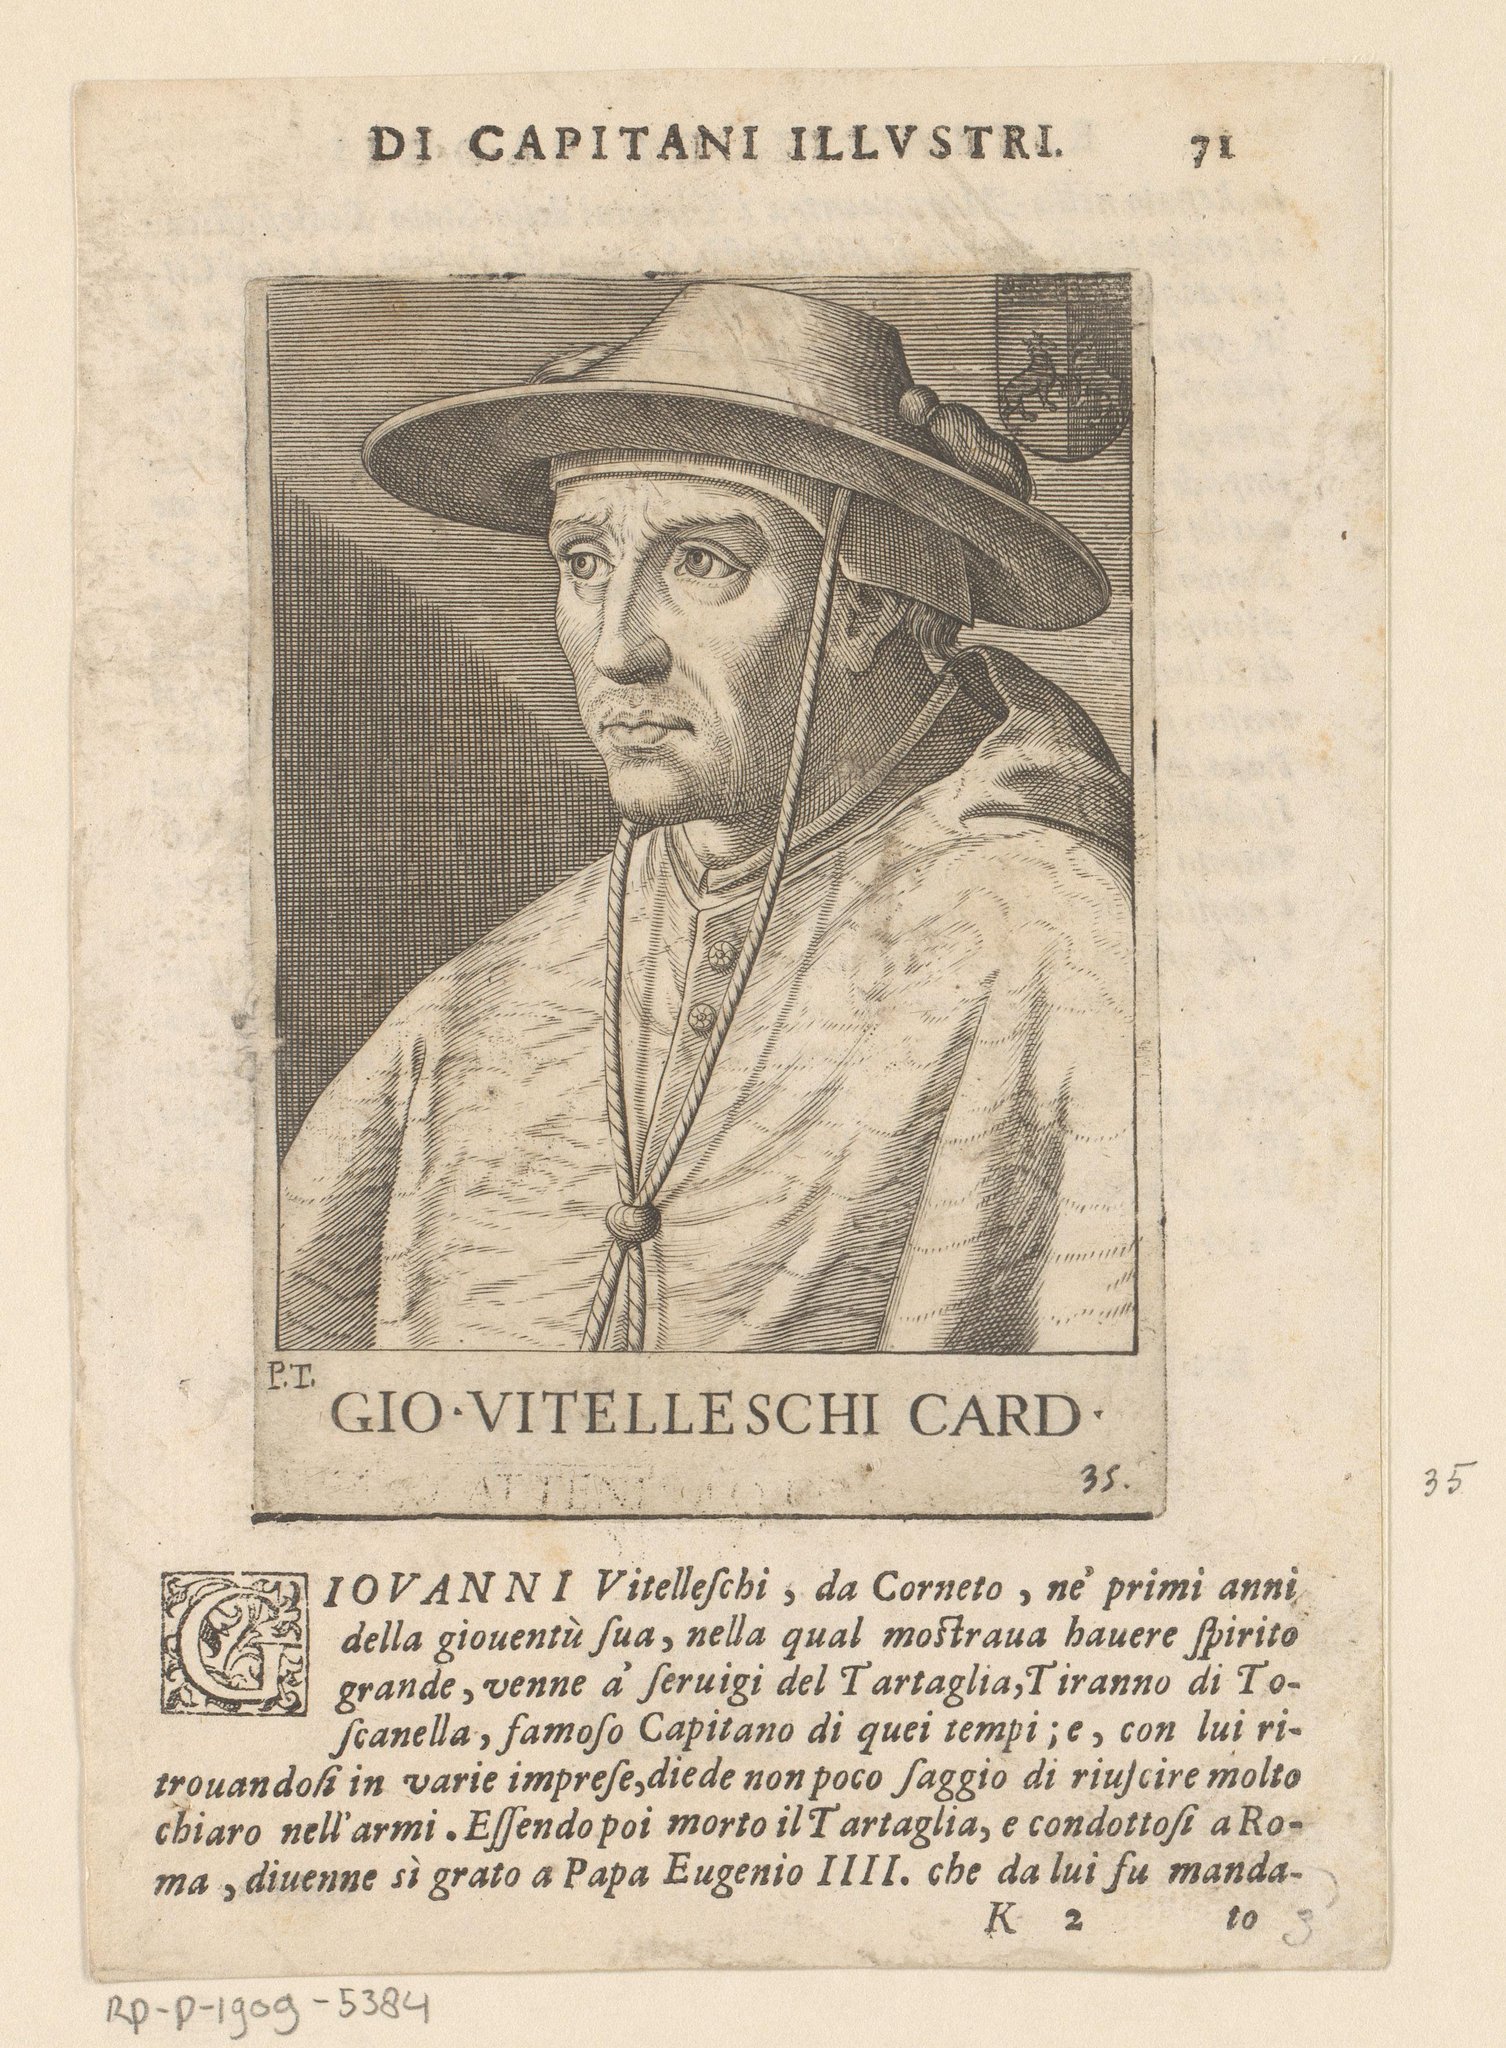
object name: book illustration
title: Gio. Vitelleschi card.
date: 1635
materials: paper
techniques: engraving, letterpress printing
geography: rome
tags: rome, cardinal, historical persons, armorial bearing, heraldry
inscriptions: collector's mark: Lugt 2228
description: Prent uit: Ritratti et elogii di capitani Illustri. Rome: Pompilio Totti en Andrea Fei, 1635, p. 71. Eerdere staat van prent in ieder geval ook gebruikt in: Ritratti di cento capitani illustri con li lor Fatti in guerra (…), Rome: Domenico Gigliotti, 1596. Latere staat van prent in ieder geval ook gebruikt in: Ritratti et elogii di capitani Illustri. Che ne'secoli moderni hanno gloriosamente guerreggiato. Rome: Filippo de'Rossi en Vitale Mascardi, 1646.